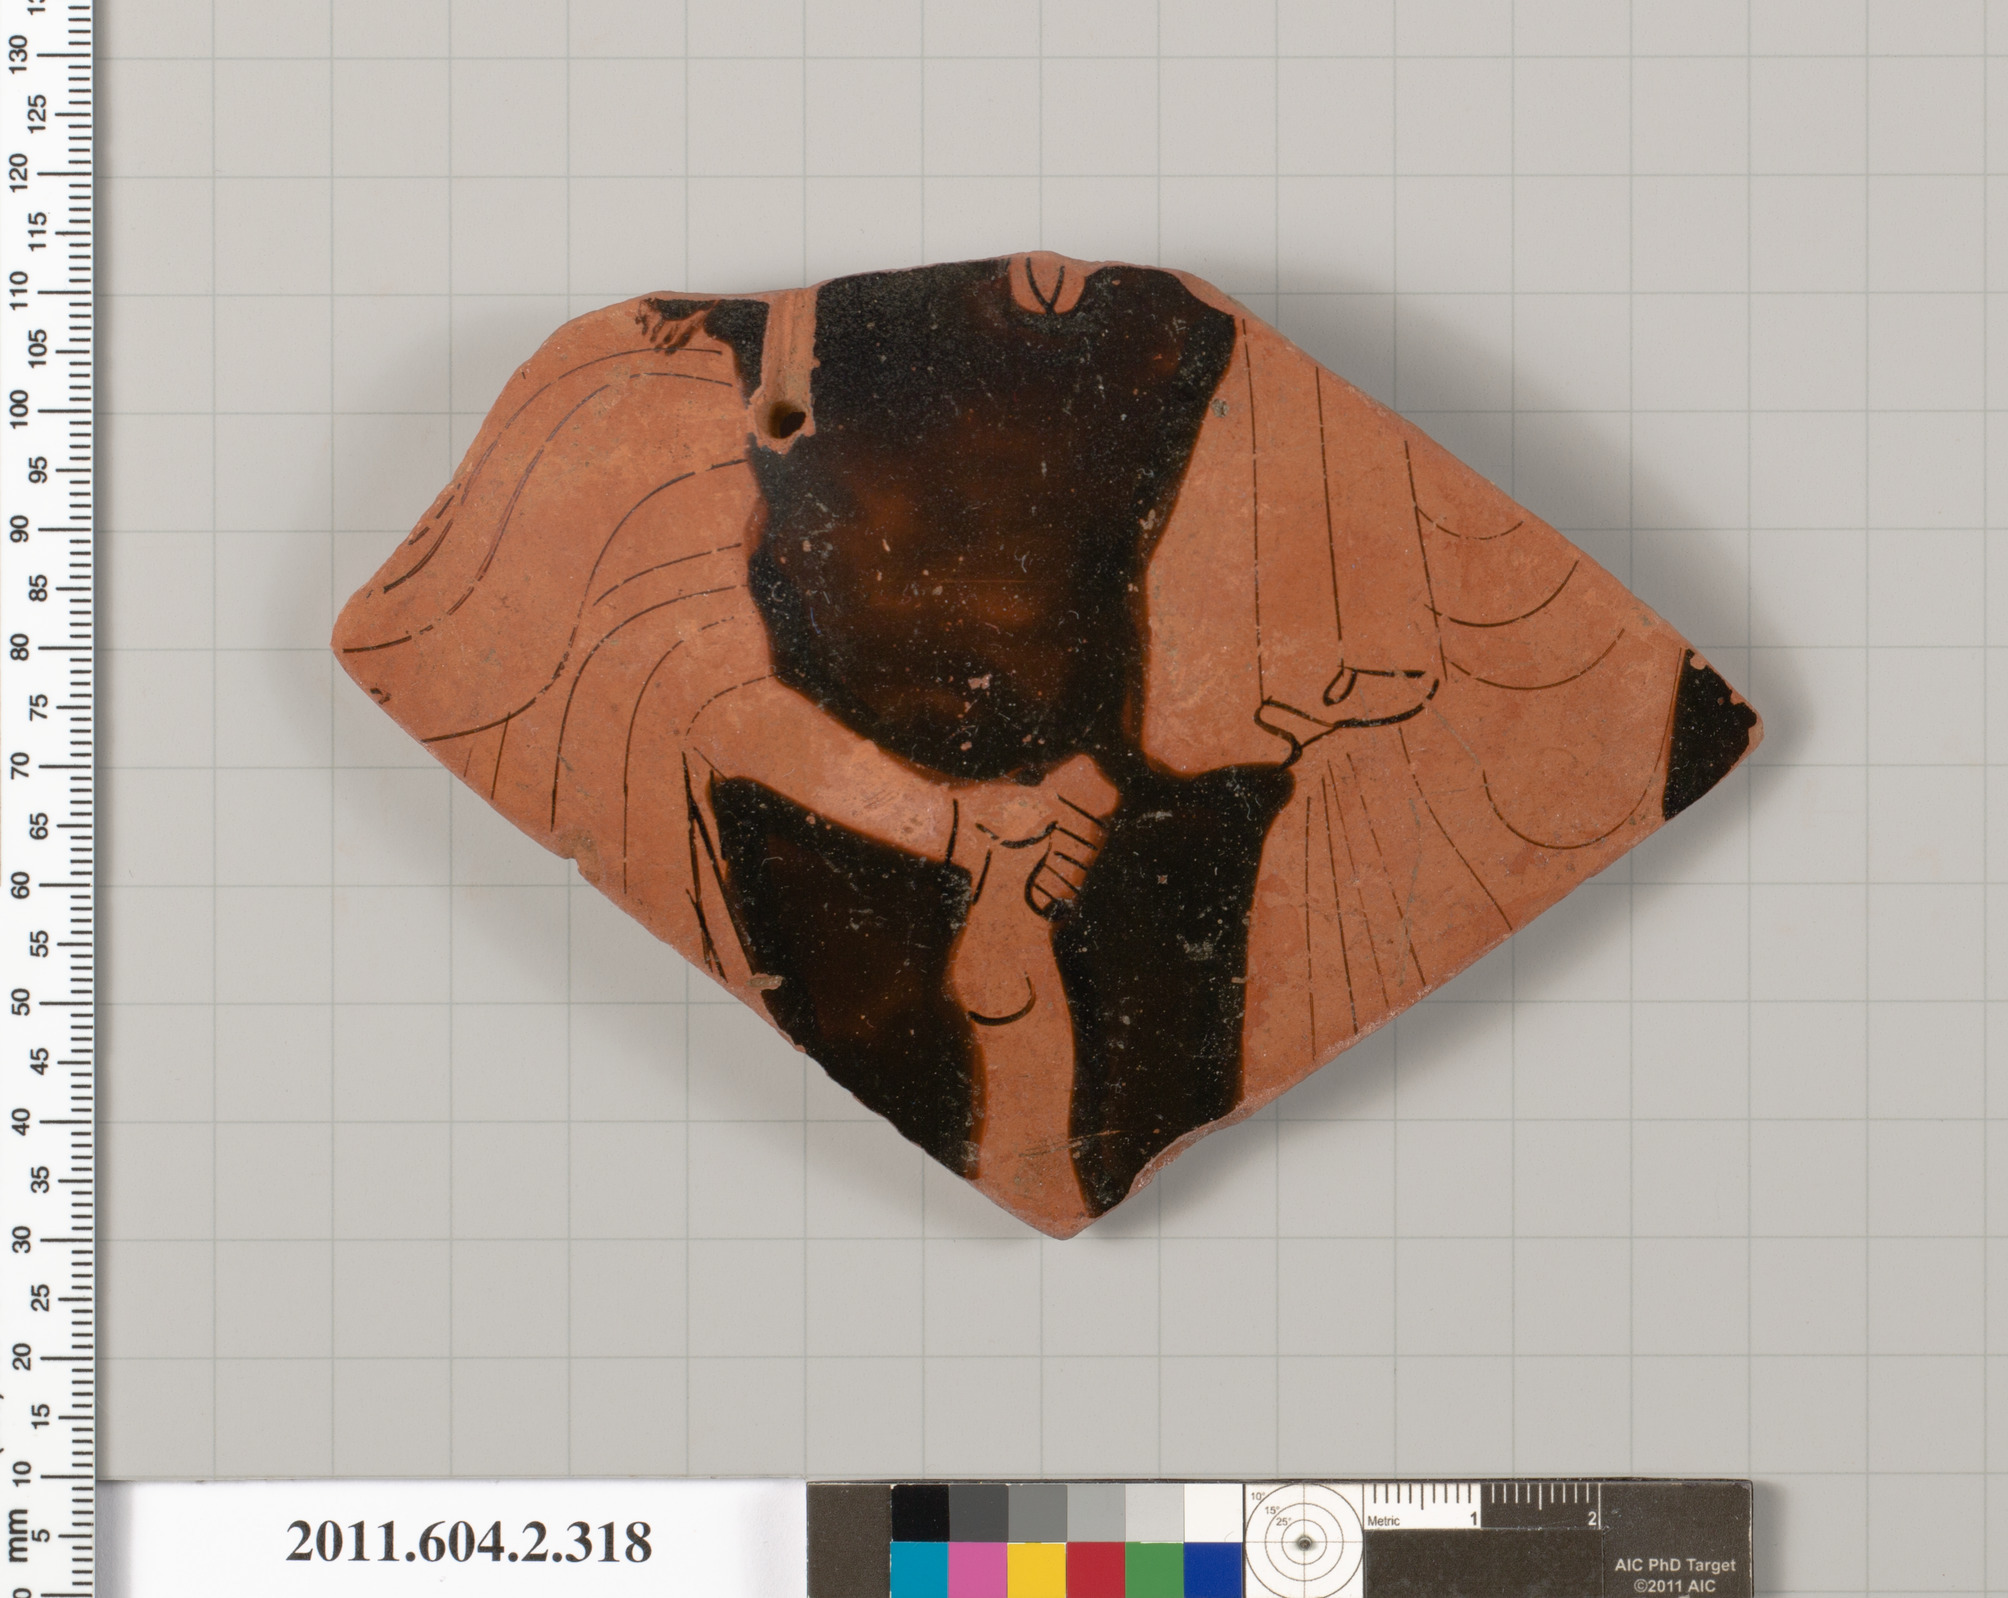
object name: column krater fragment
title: Terracotta fragment of a column-krater (bowl for mixing wine and water)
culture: greek, attic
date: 440-430 BCE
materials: terracotta